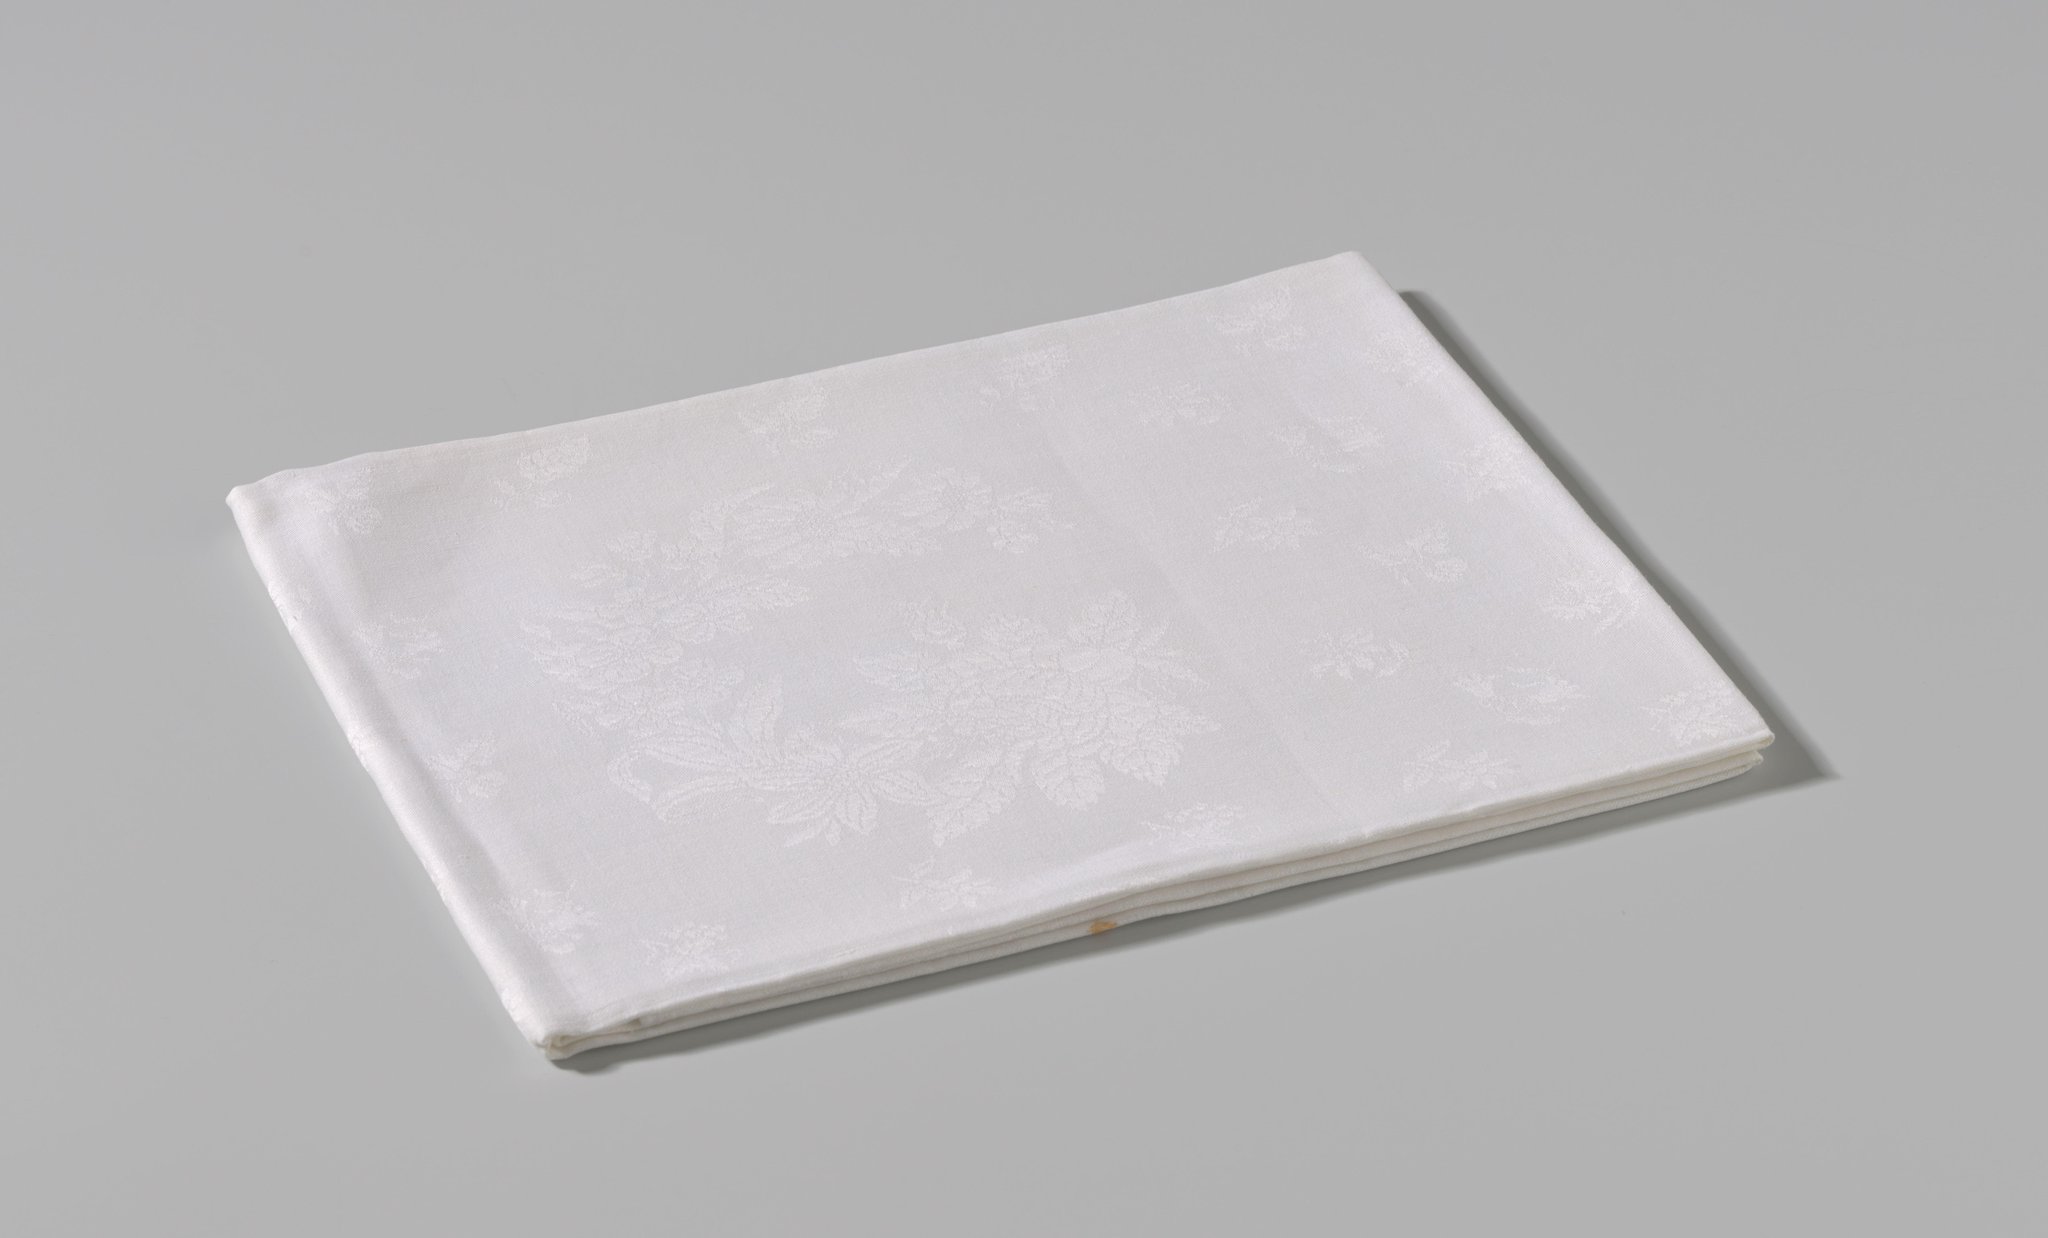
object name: napkin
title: Servet van linnendamast met een bloempatroon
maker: Anonymous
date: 1800-1850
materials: linen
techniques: damask, weave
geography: netherlands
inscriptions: mark: ‘.L.’, mark: ‘BG 24’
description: Servet van linnendamast met een bloempatroon. Middenveld met strooimotieven, liggende en lopende randen, respectievelijk bloemmotieven en bladrand en liggende rand met dambordmotief. Het servet hoort bij zeven servetten (BK-1976-121-A t/m BK-1976-121-H) en een tafellaken (BK-1976-120).